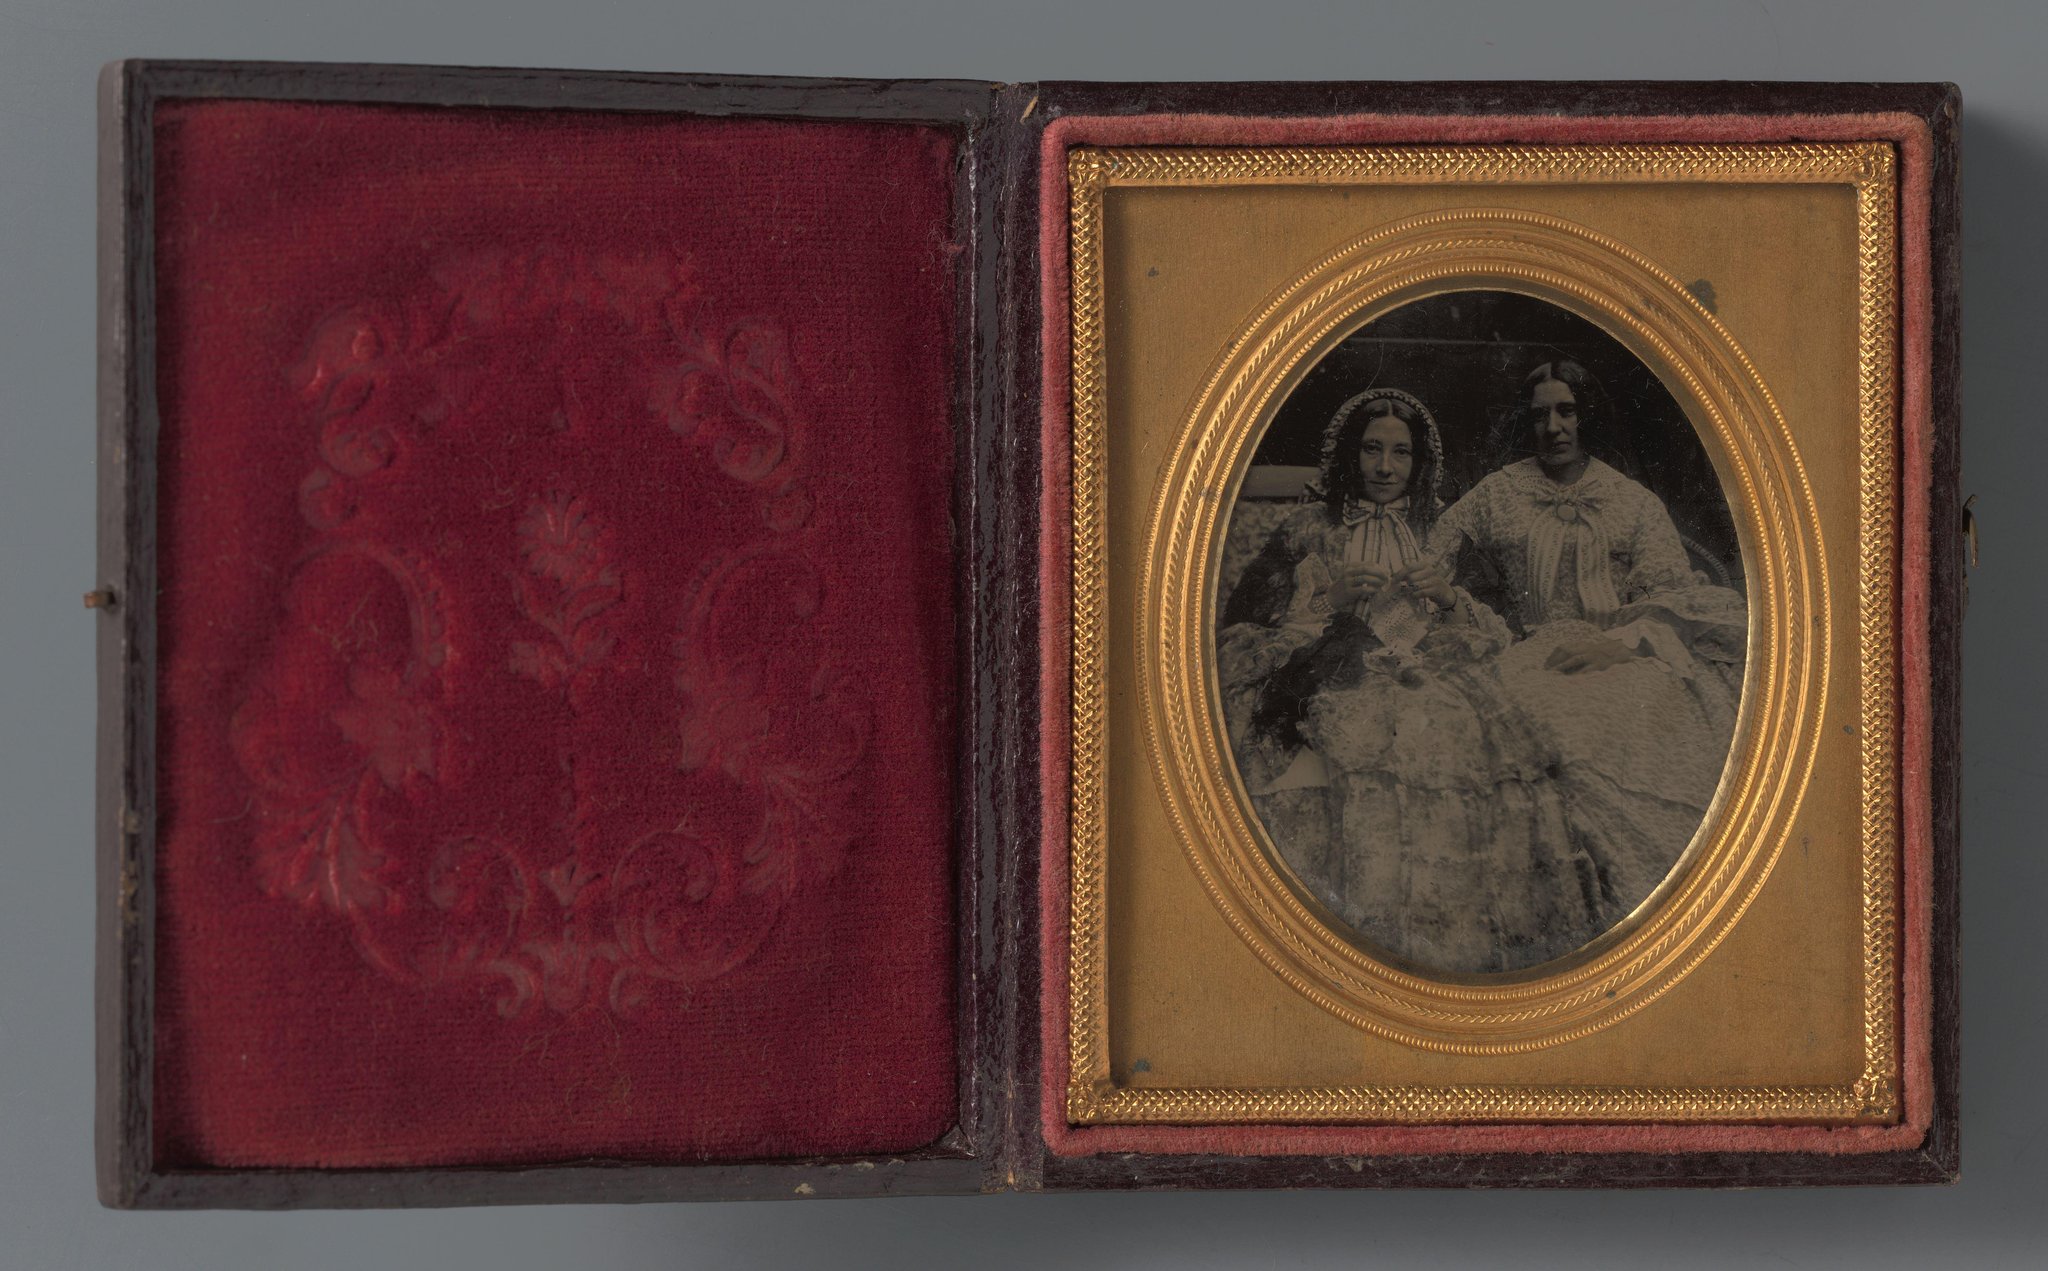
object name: photograph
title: Portret van twee onbekende vrouwen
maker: Anonymous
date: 1857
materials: glass, leather, metal, velvet, wood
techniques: ambrotype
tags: adult man (+ two persons), historical persons - bb - woman